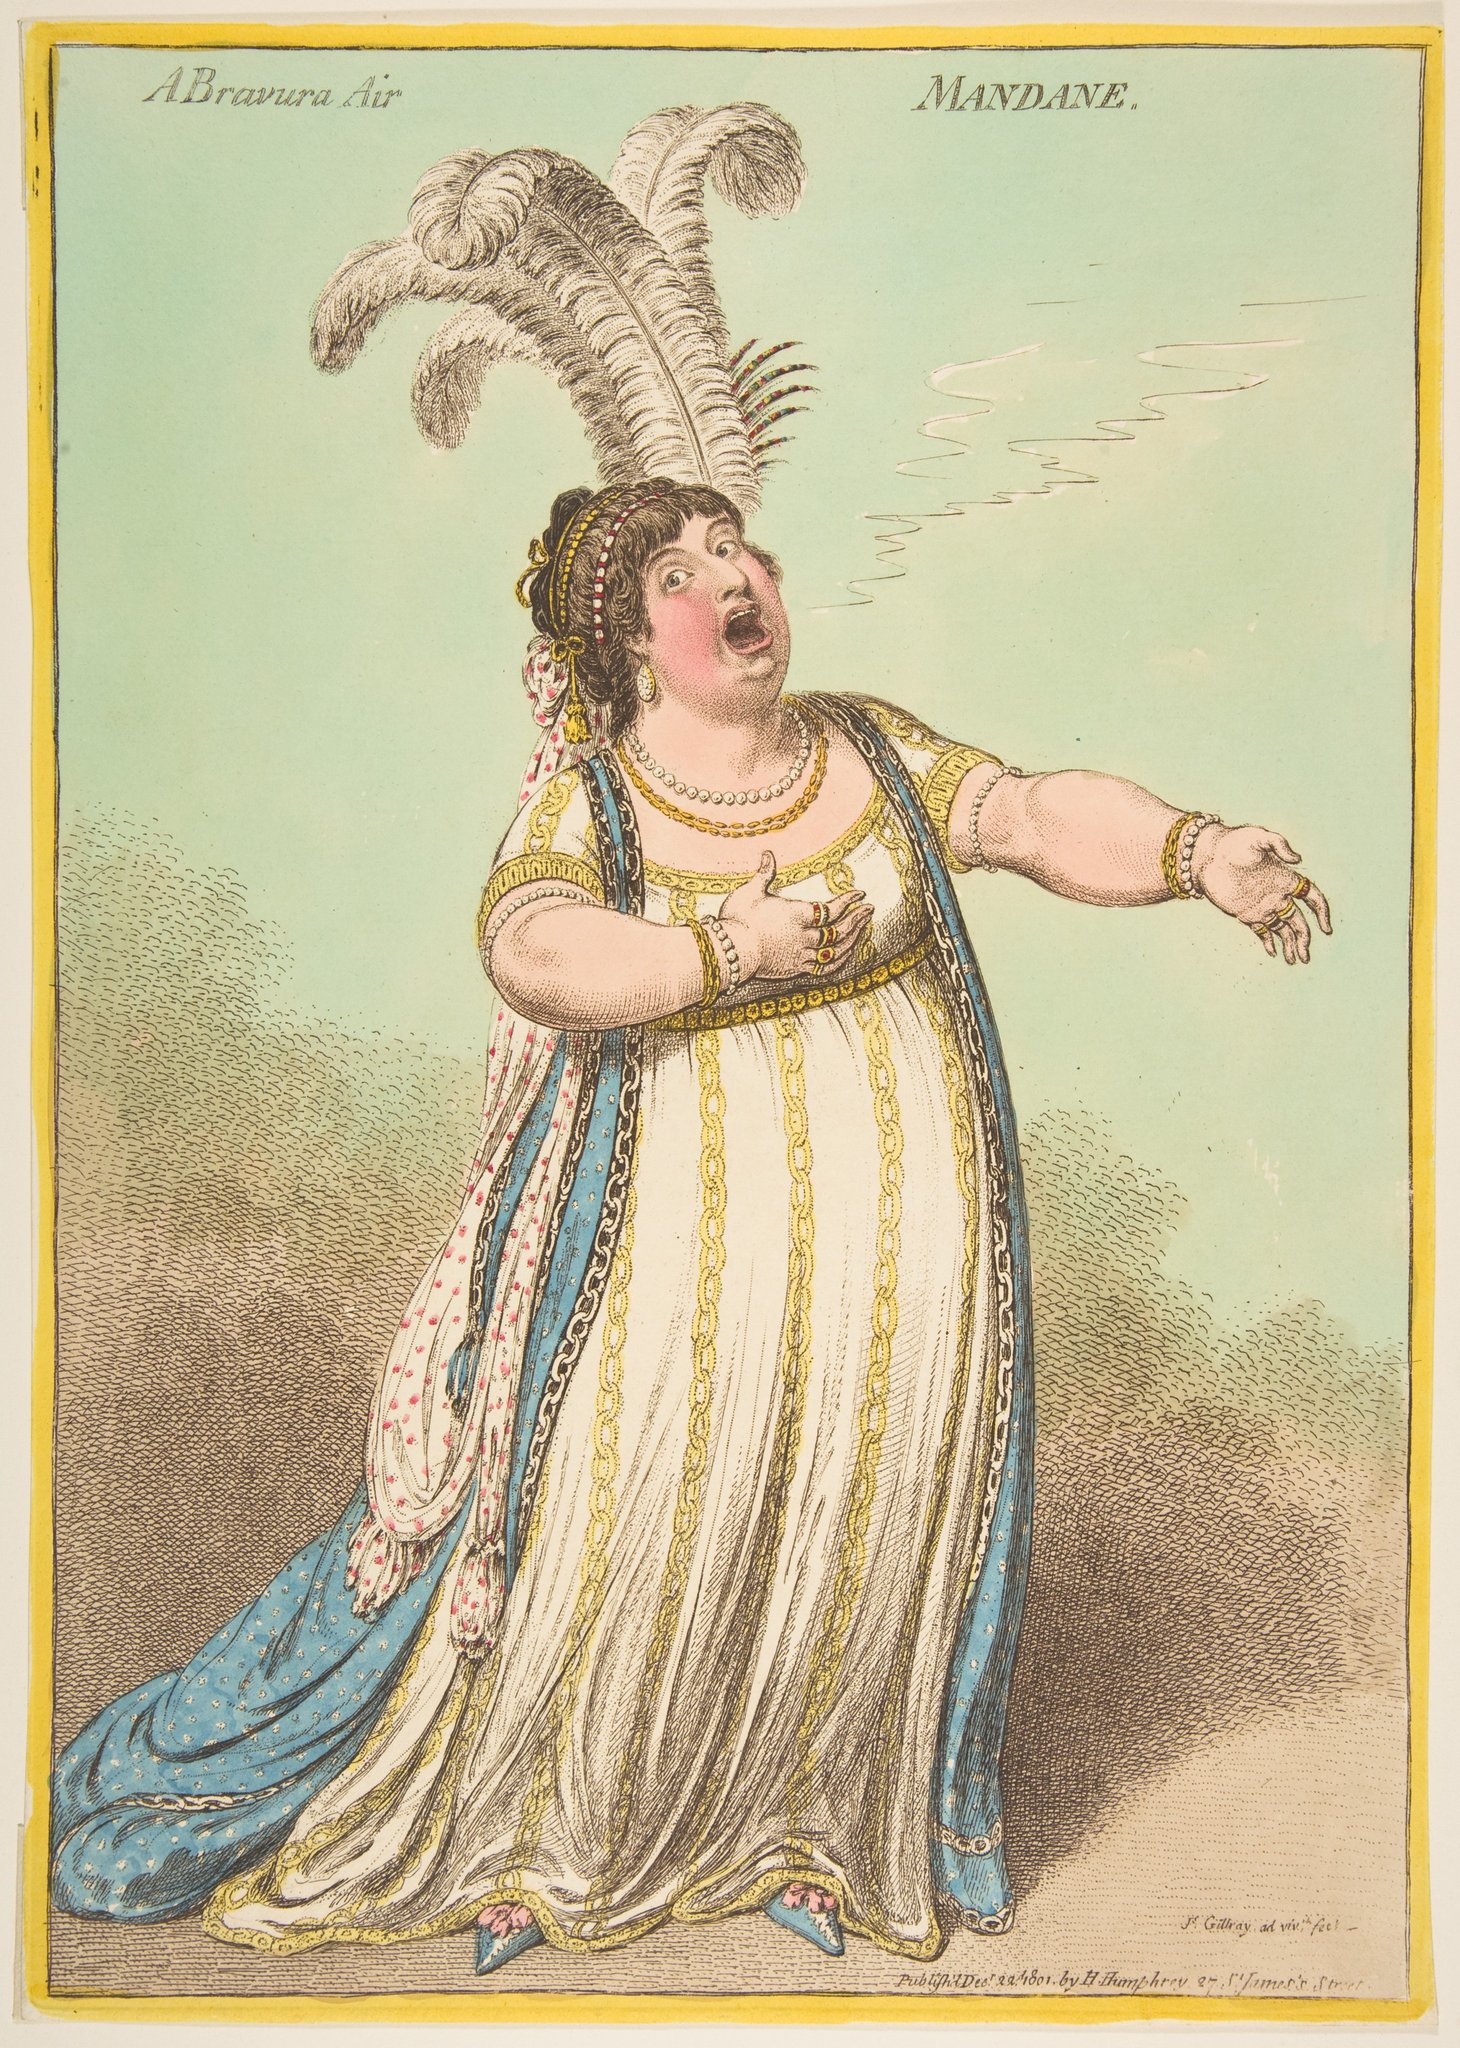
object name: print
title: A Bravura Air. Mandane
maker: james gillray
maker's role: artist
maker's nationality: british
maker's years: 1756-1815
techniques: etching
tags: women